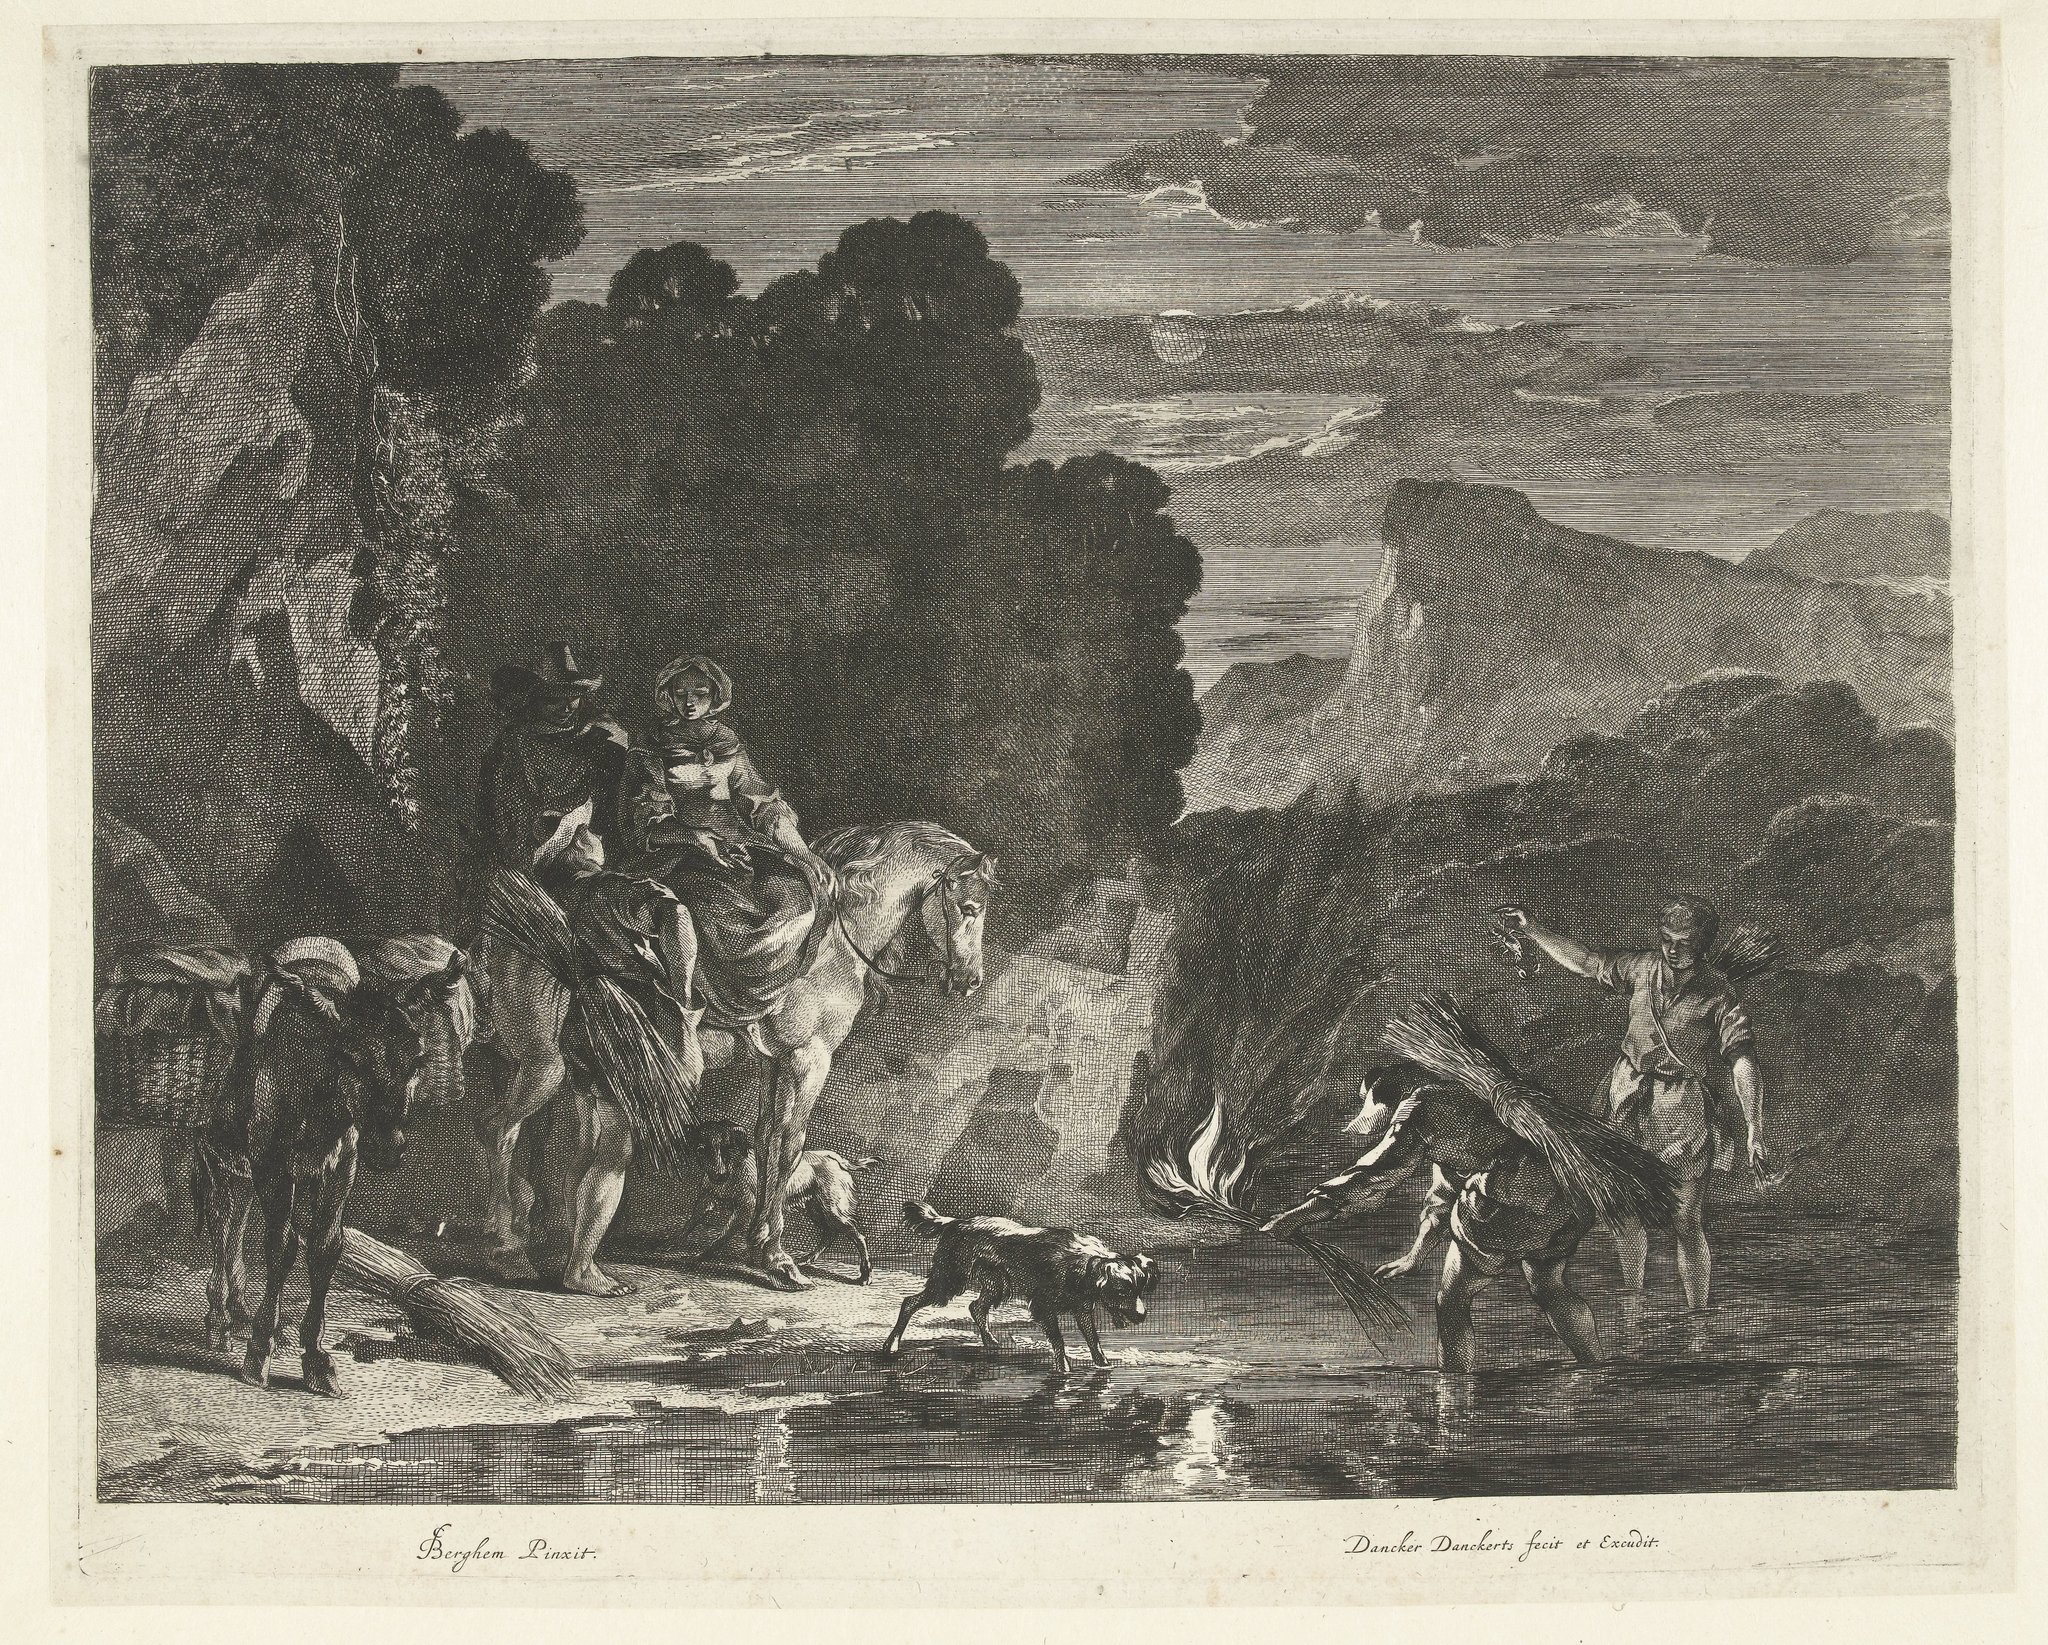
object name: print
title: Krabvissers bij nacht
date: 1660-1666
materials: paper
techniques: etching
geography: amsterdam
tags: crustaceans: crab, rocks, fisherman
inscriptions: collector's mark: Lugt 240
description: Krabvissers bij nacht. Vissers vangen krabben bij het licht van brandende bossen riet. Een rijk gekleed stel te paard praat op de oever met een visser. Prent nummer 4 uit serie van vier prenten met de Tijden van de dag.